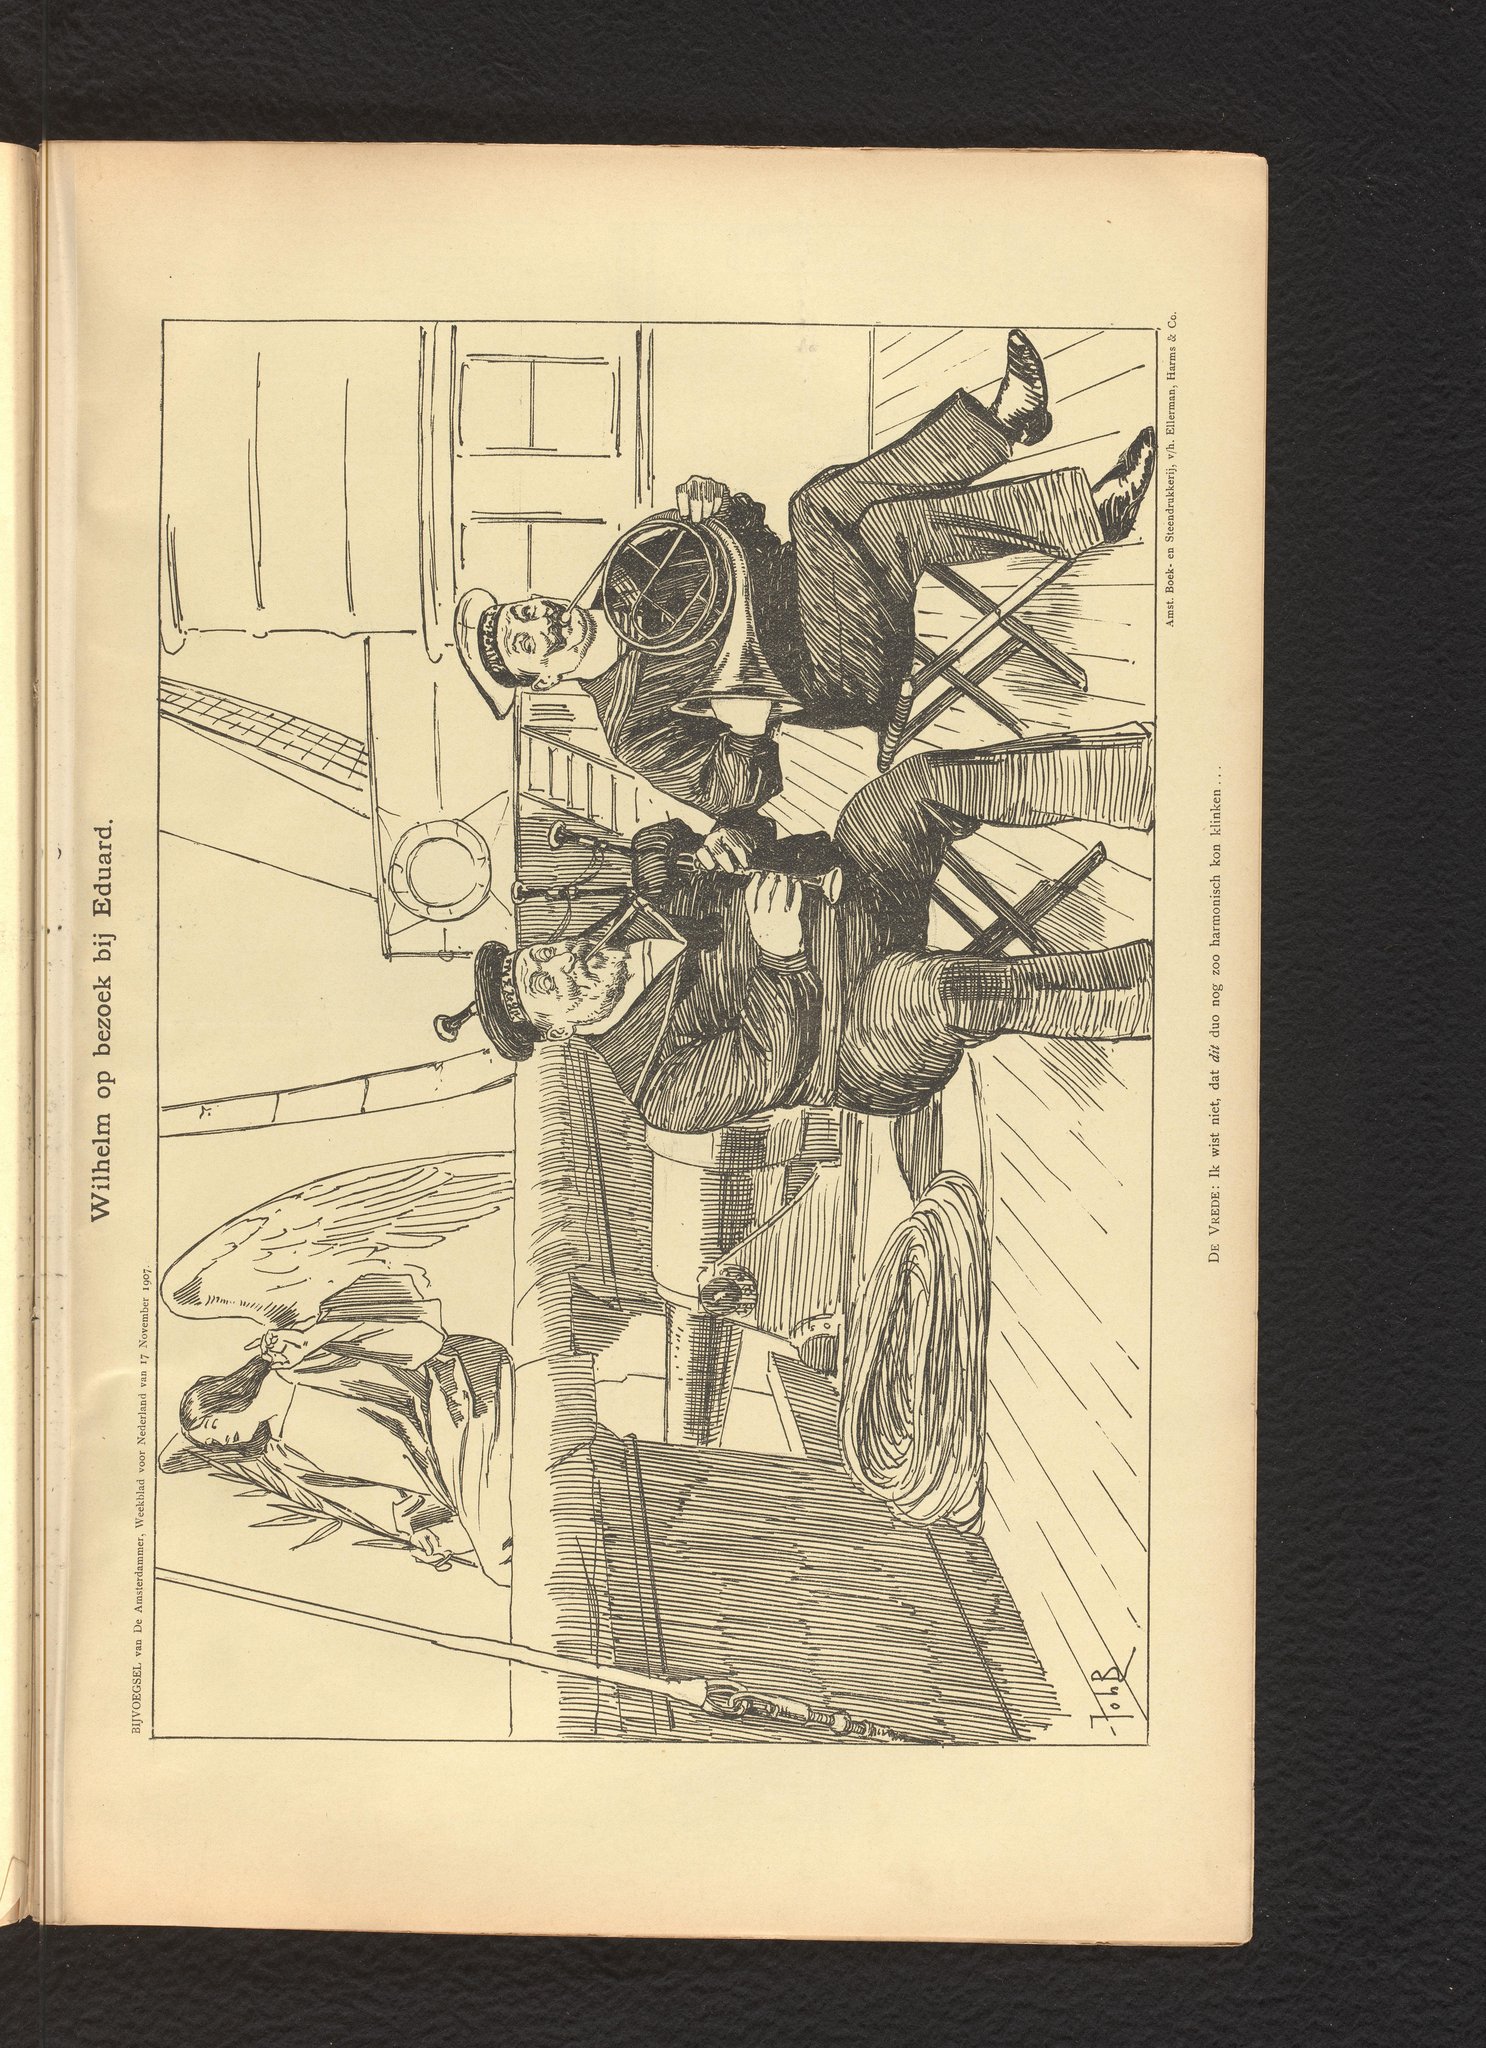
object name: cartoon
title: Wilhelm op bezoek bij Eduard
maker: johan braakensiek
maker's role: draughtsman, print maker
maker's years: 1858-1940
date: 1907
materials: paper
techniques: lithograph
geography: amsterdam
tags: wilhelm ii (keizer van duitsland), symbols, allegories of peace, 'pax'; 'pace' (ripa), more than one musician with instrument - cc - 'concert champêtre', political caricatures and satires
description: De vredesengel hoort tevreden hoe de Engelse koning Edward VII en de Duitse keizer Wilhelm II samen op het dek van een oorlogsschip muziek maken.